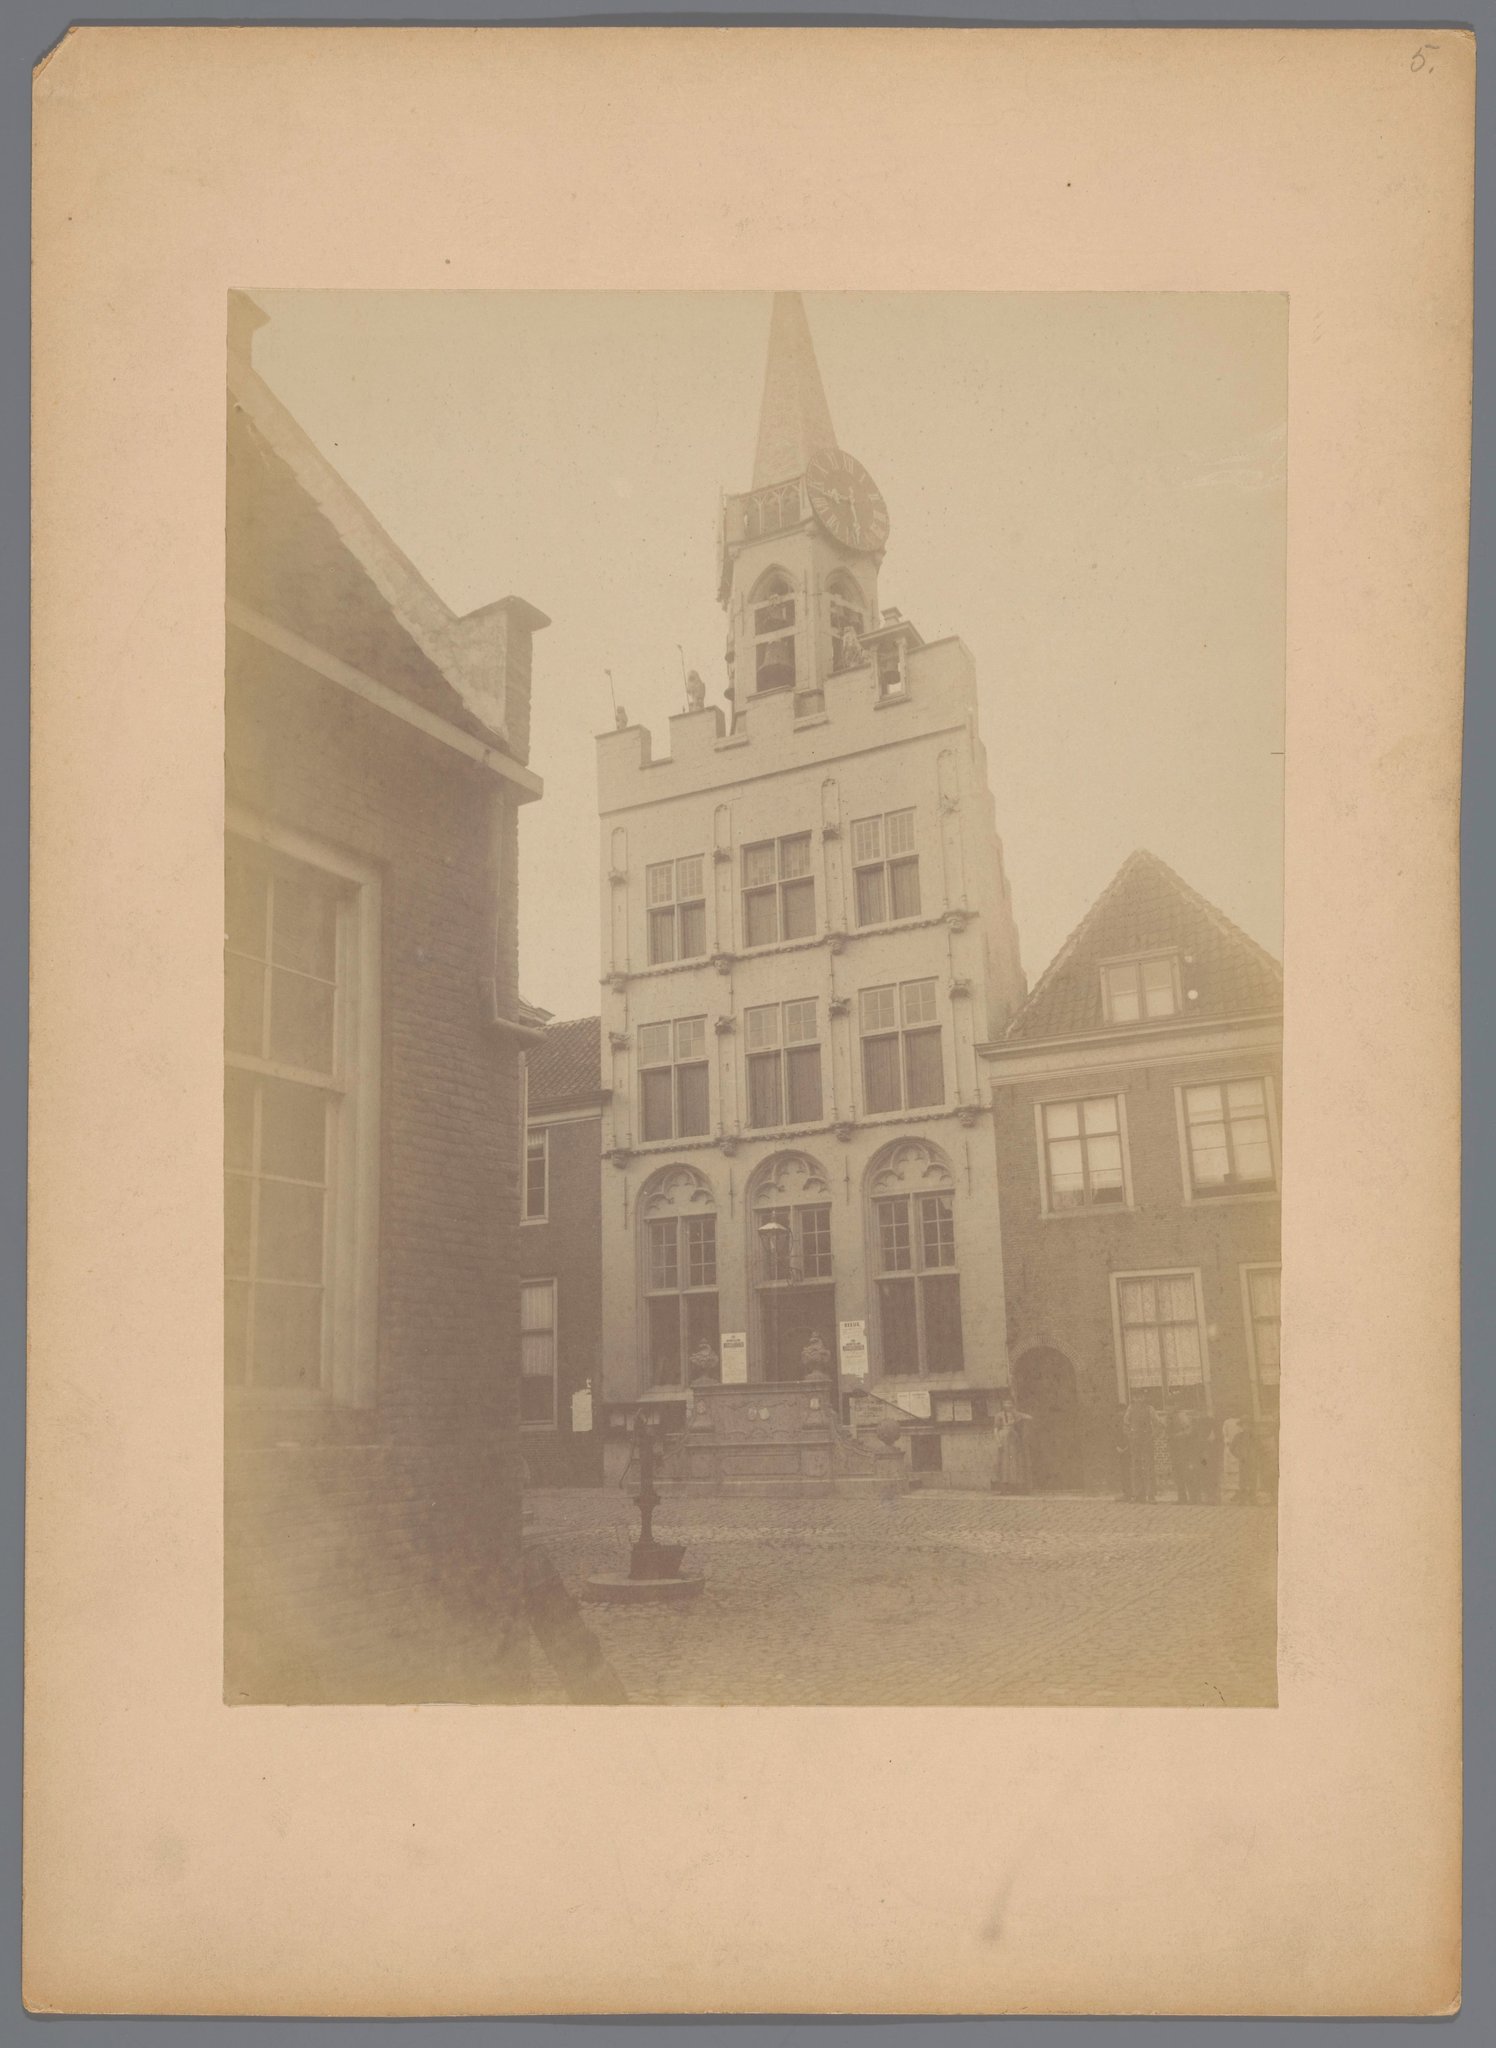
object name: photograph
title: Exterieur van het stadhuis van Tholen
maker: Anonymous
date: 1875-1900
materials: cardboard, photographic support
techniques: albumen print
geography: tholen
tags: townhall, façade (of house or building)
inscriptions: inscription: ‘Tholen Raadhuis’, collector's mark: ‘RIJKS-NORMAALSCHOOL VOOR TEEKENONDERWIJZERS. AMSTERDAM’